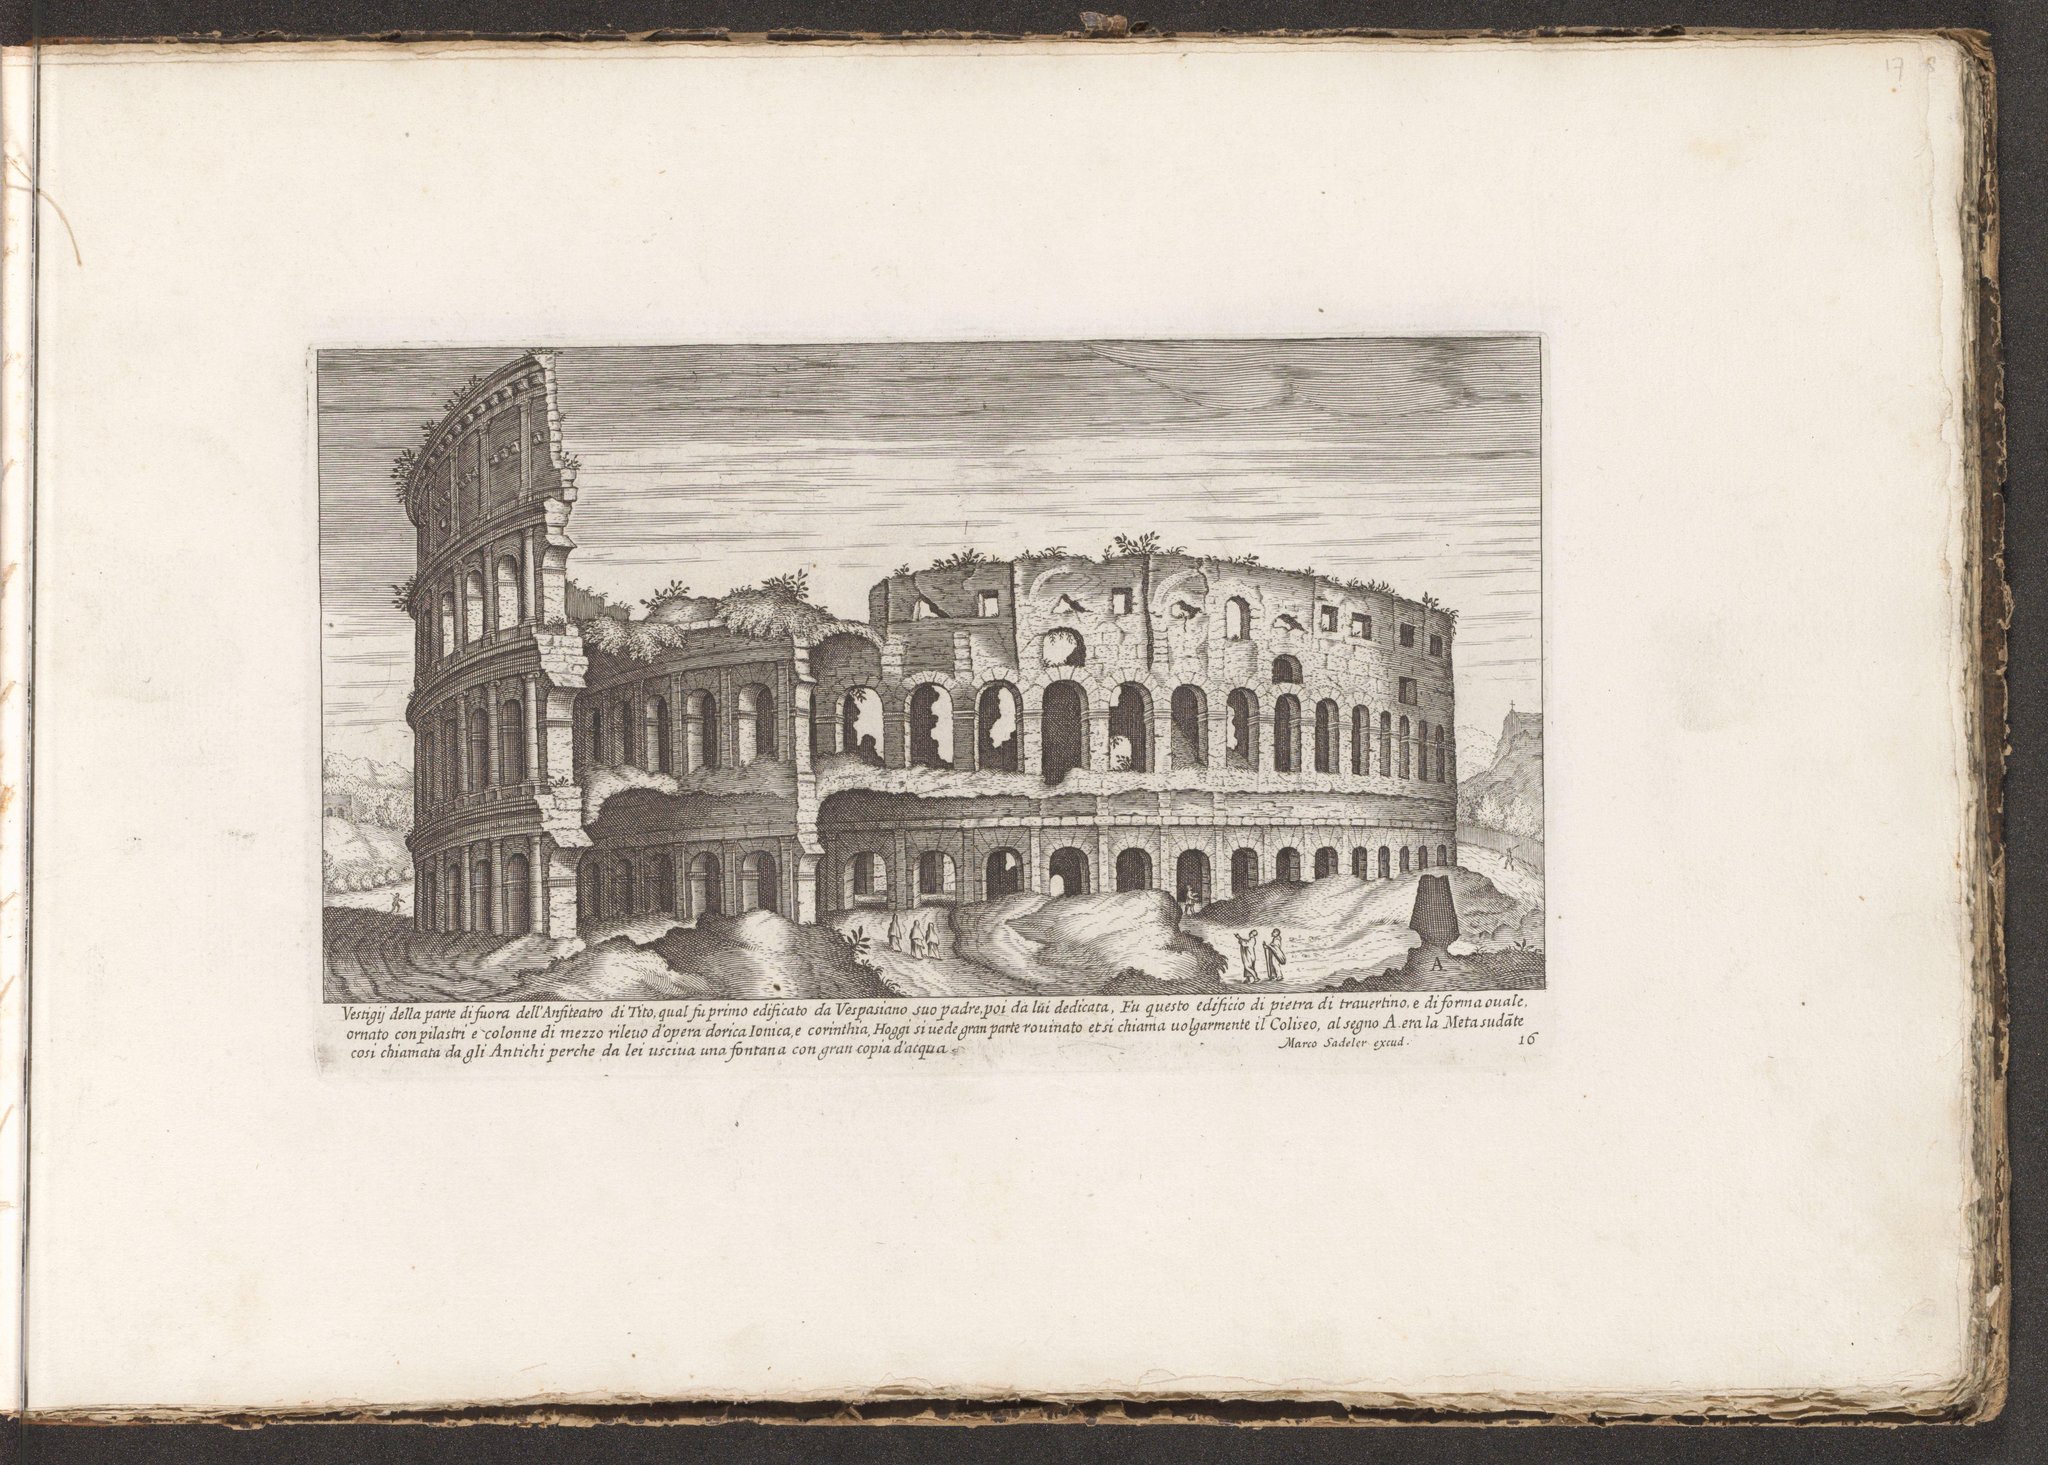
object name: album leaf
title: Colosseum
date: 1680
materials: paper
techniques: engraving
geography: prague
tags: rome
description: Gezicht op het Colosseum, het Flavisch amfitheater in Rome. Rechts de resten van de Meta Sudans, een monumentale fontein in het oude Rome. In de ondermarge drie regels tekst in het Italiaans. De prent maakt deel uit van een album.